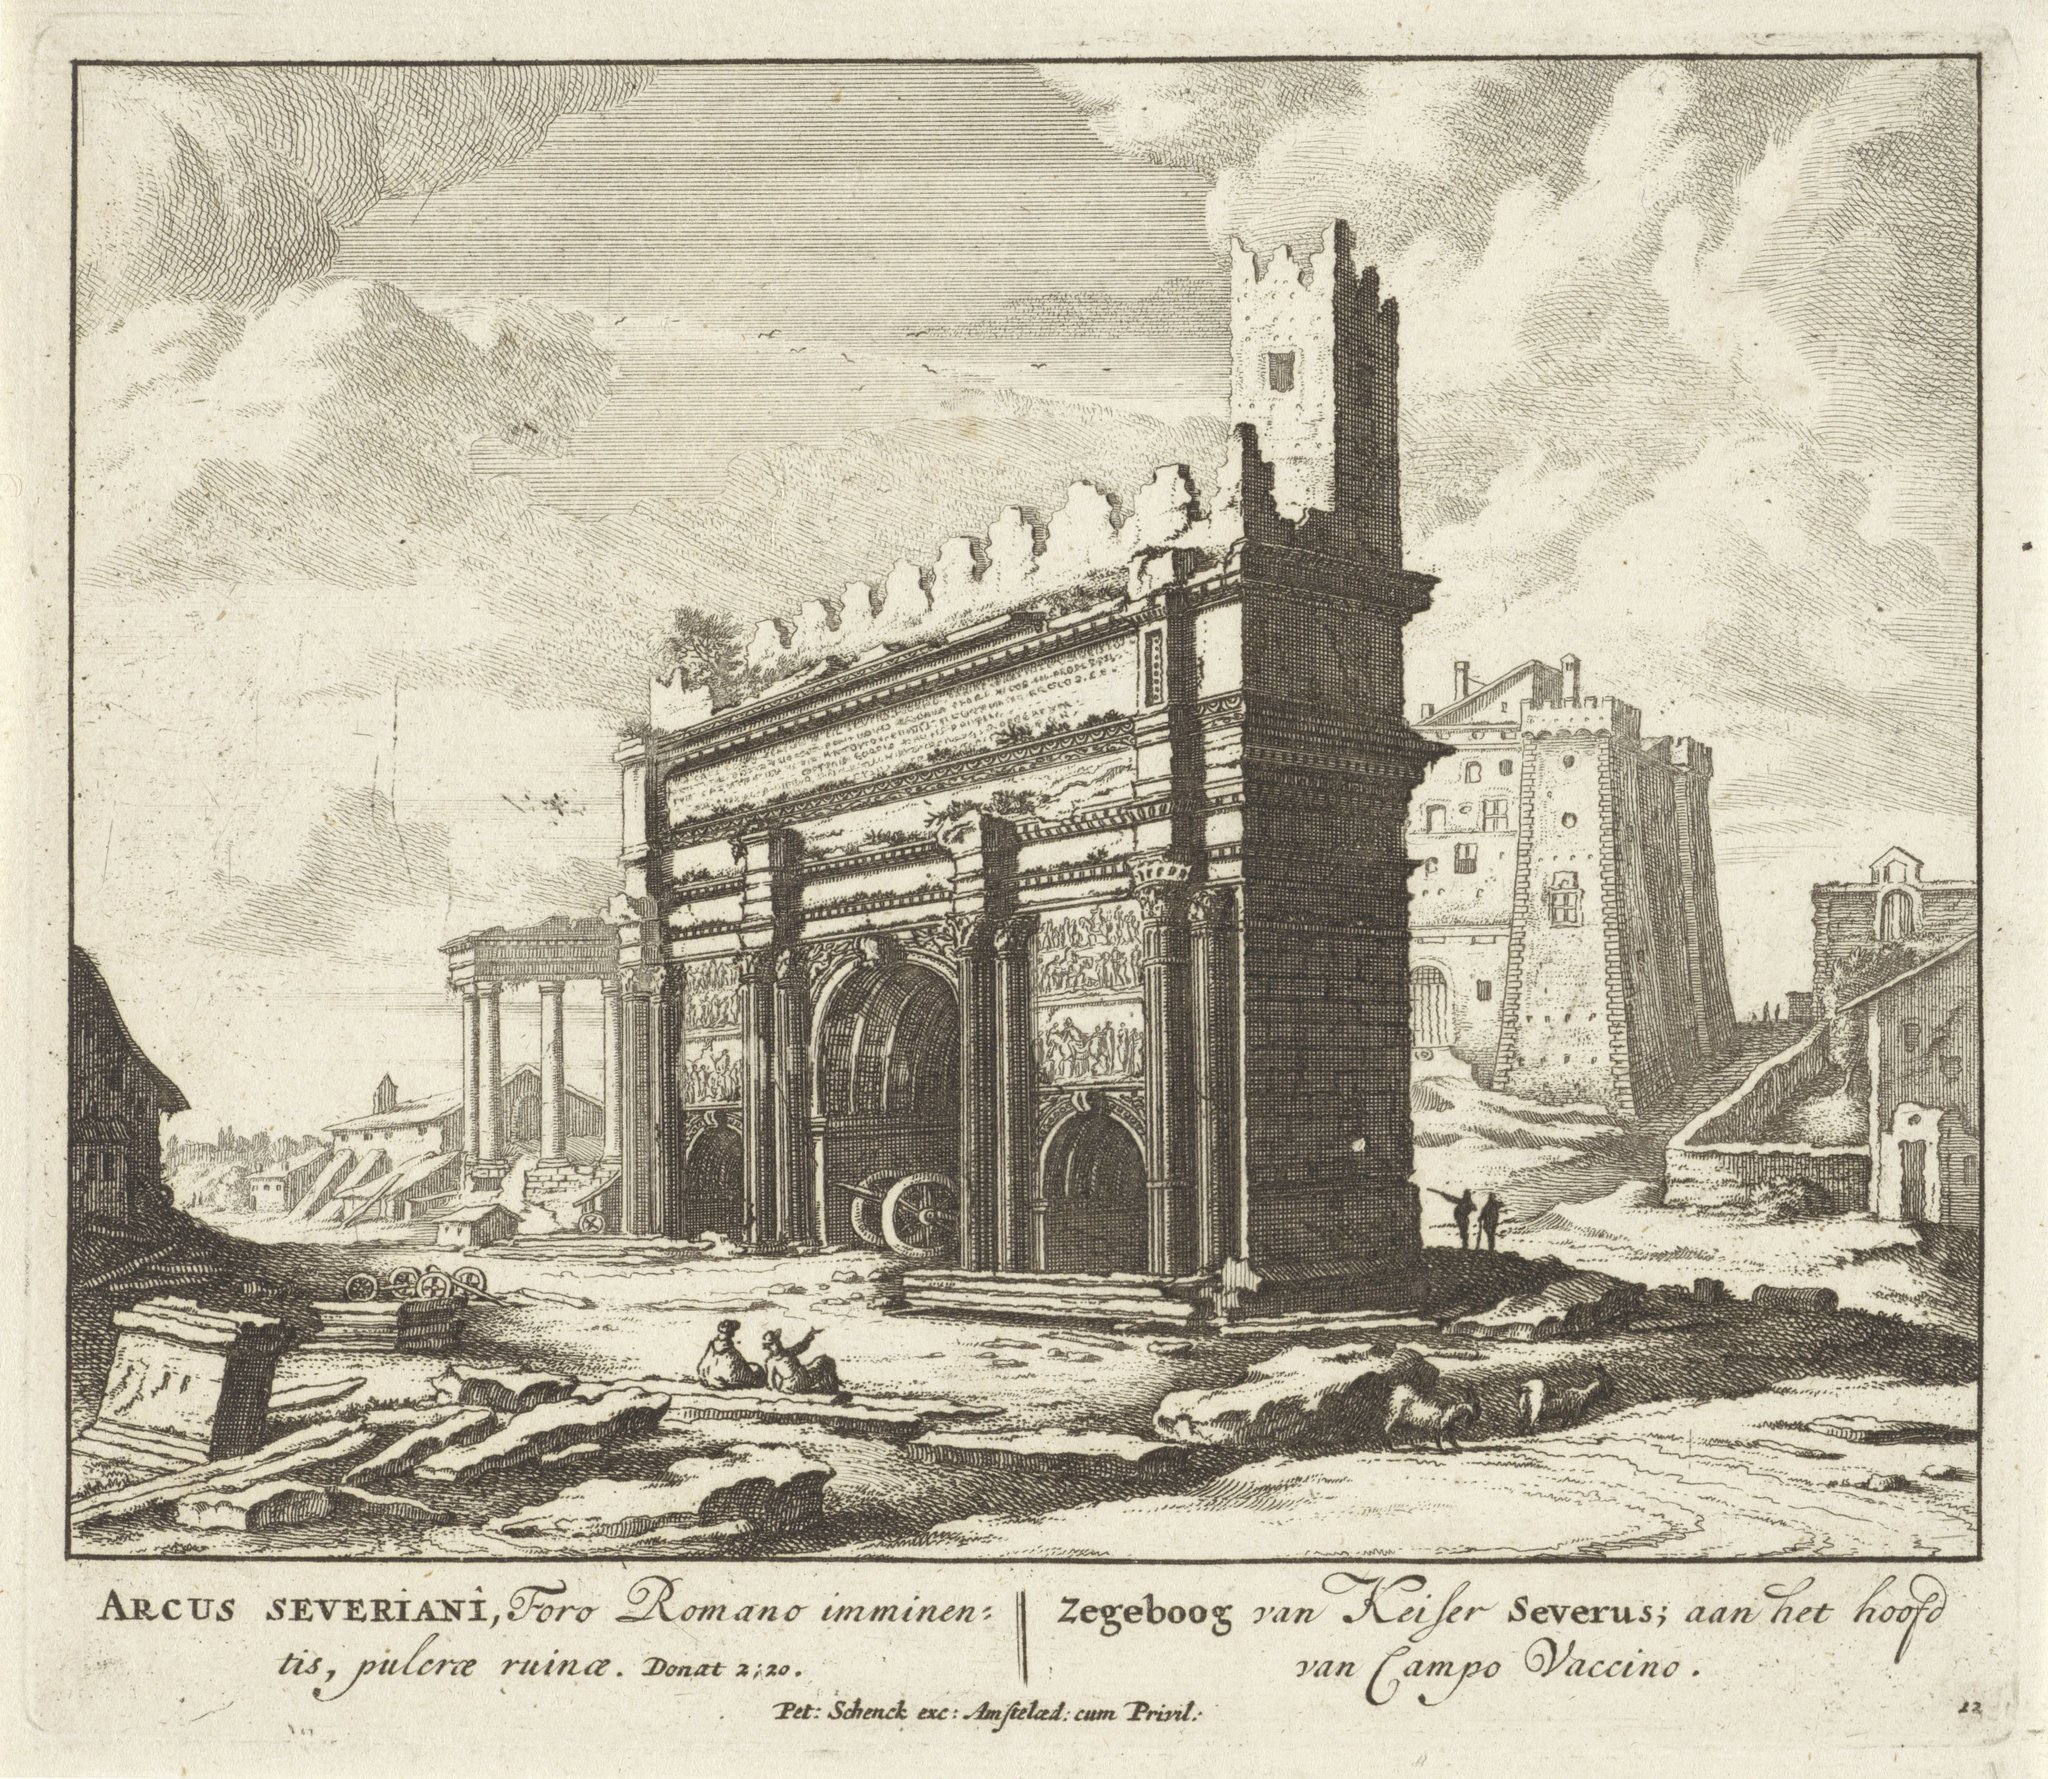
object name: print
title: Gezichten in Rome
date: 1675-1711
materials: paper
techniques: etching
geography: amsterdam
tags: triumphal arch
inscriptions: collector's mark: Lugt 2228